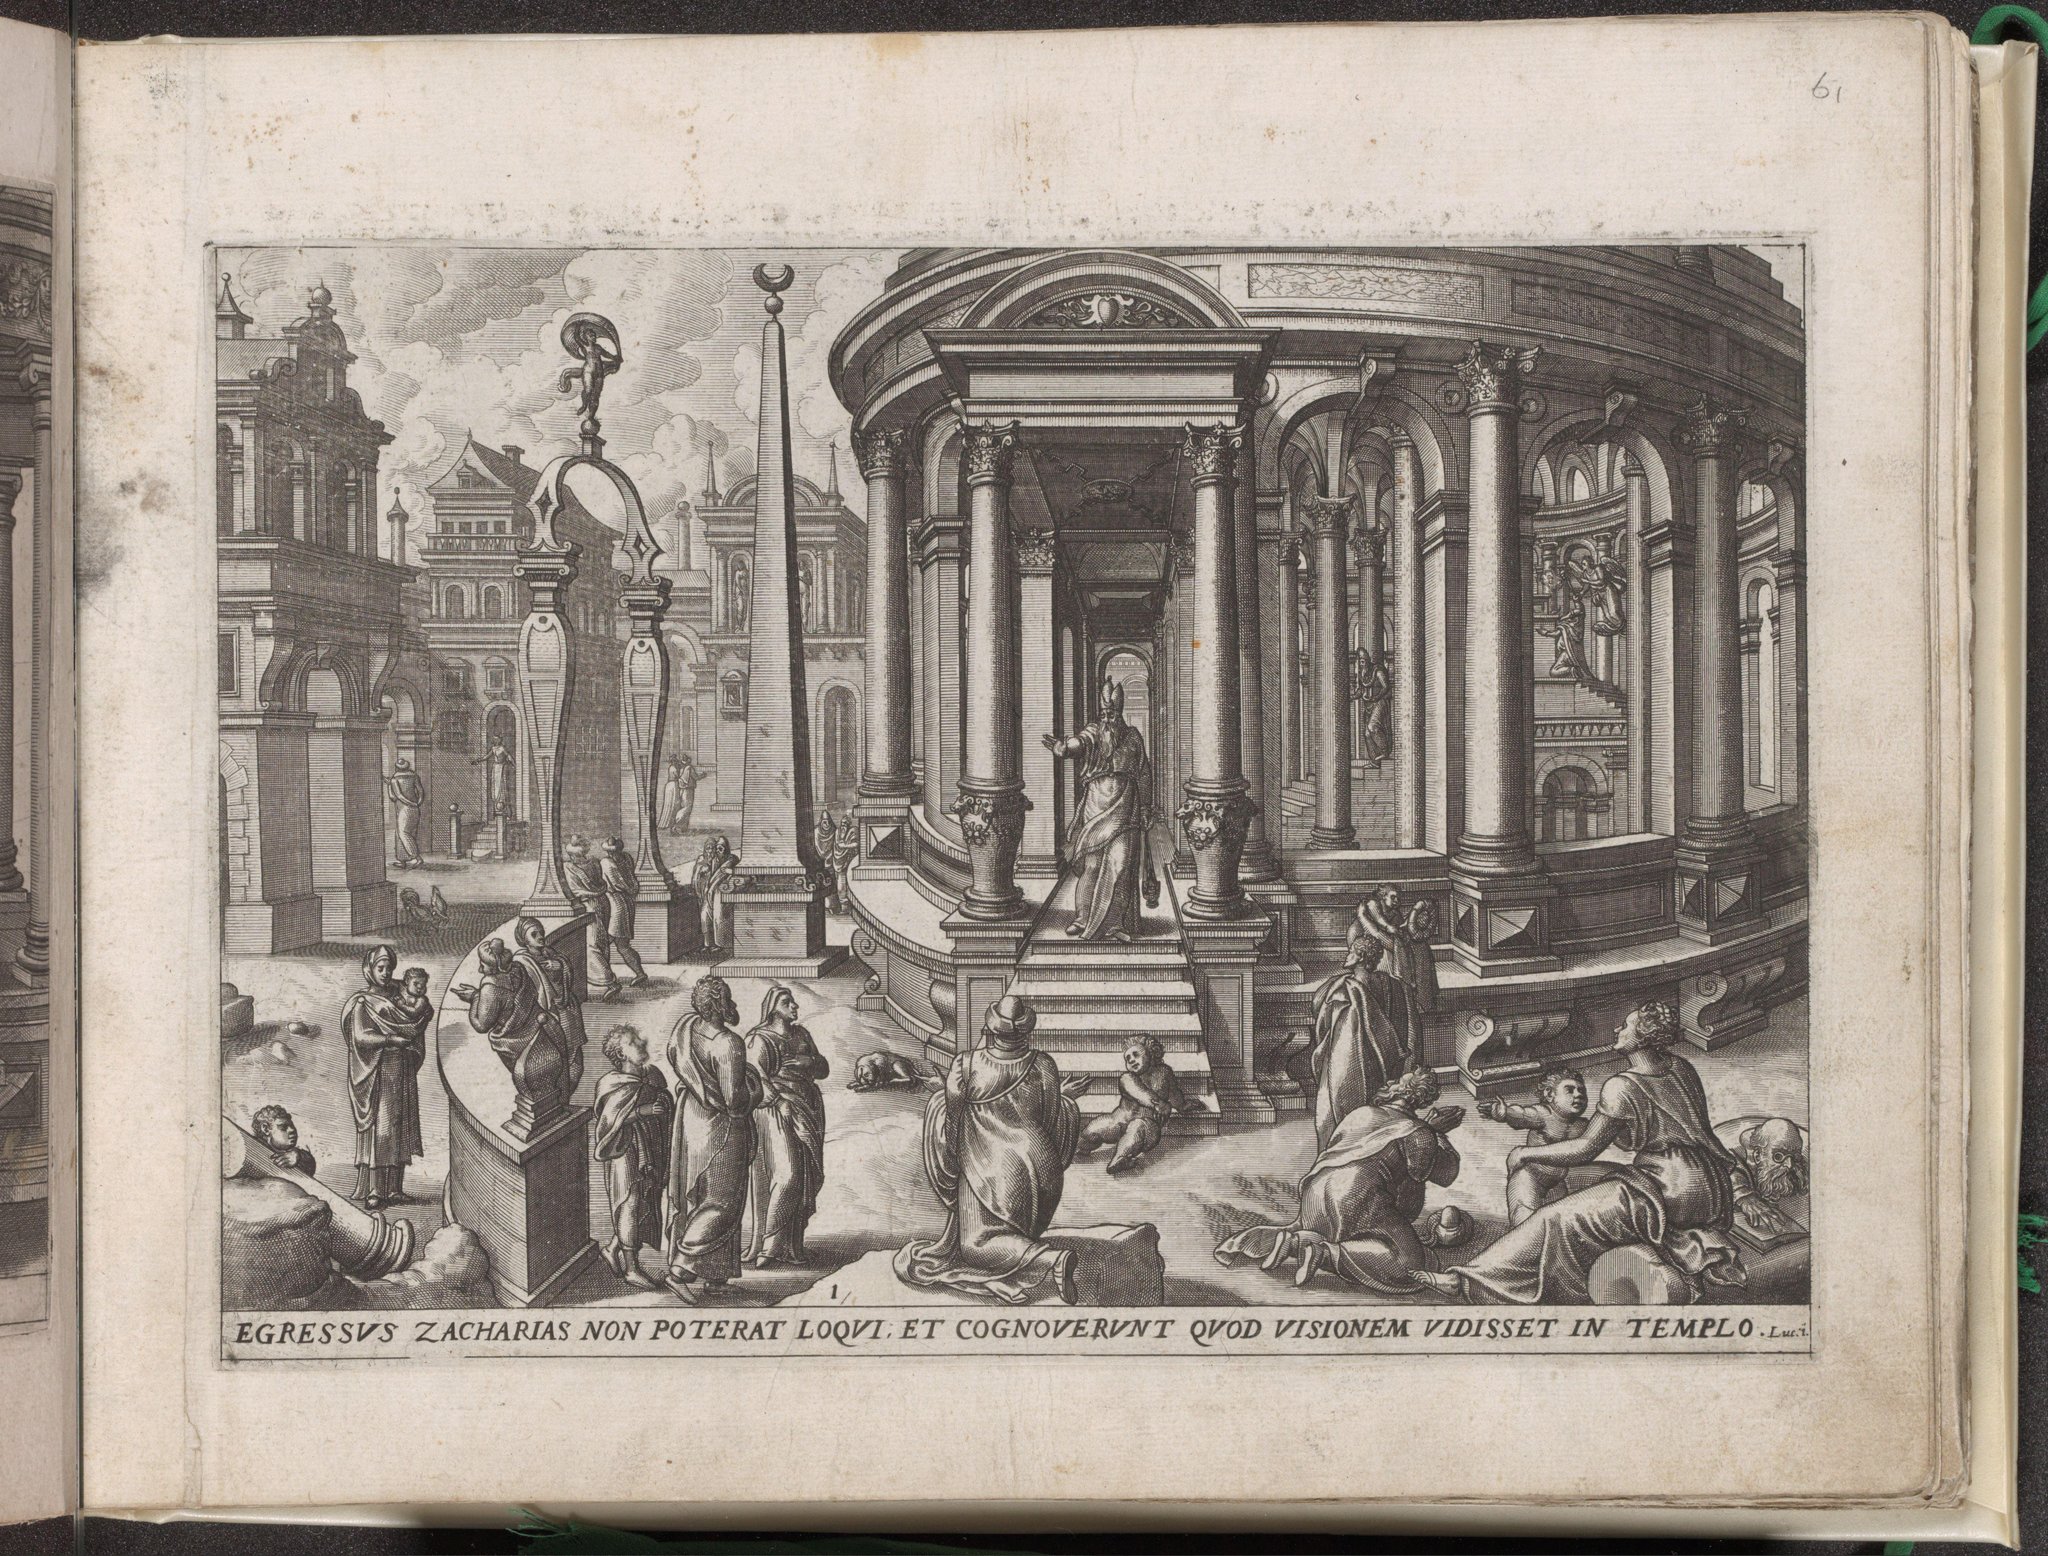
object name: print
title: Gebeurtenissen in en rond de tempel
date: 1570-1574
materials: paper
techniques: engraving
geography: antwerp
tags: zacharias speechless before the people, being silent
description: In de tempel verschijnt de engel Gabriël aan de hogepriester Zacharias, die hem zegt dat hij een zoon zal krijgen. Omdat Zacharias dit niet gelooft wordt hem zijn spraakvermogen ontnomen. Als hij verschijnt op de trappen van de tempel om de menigte toe te spreken kan hij niets meer zeggen. Onder de voorstelling een verwijzing in het Latijn naar de Bijbeltekst in Luc. 1. Deze prent maakt deel uit van een album.